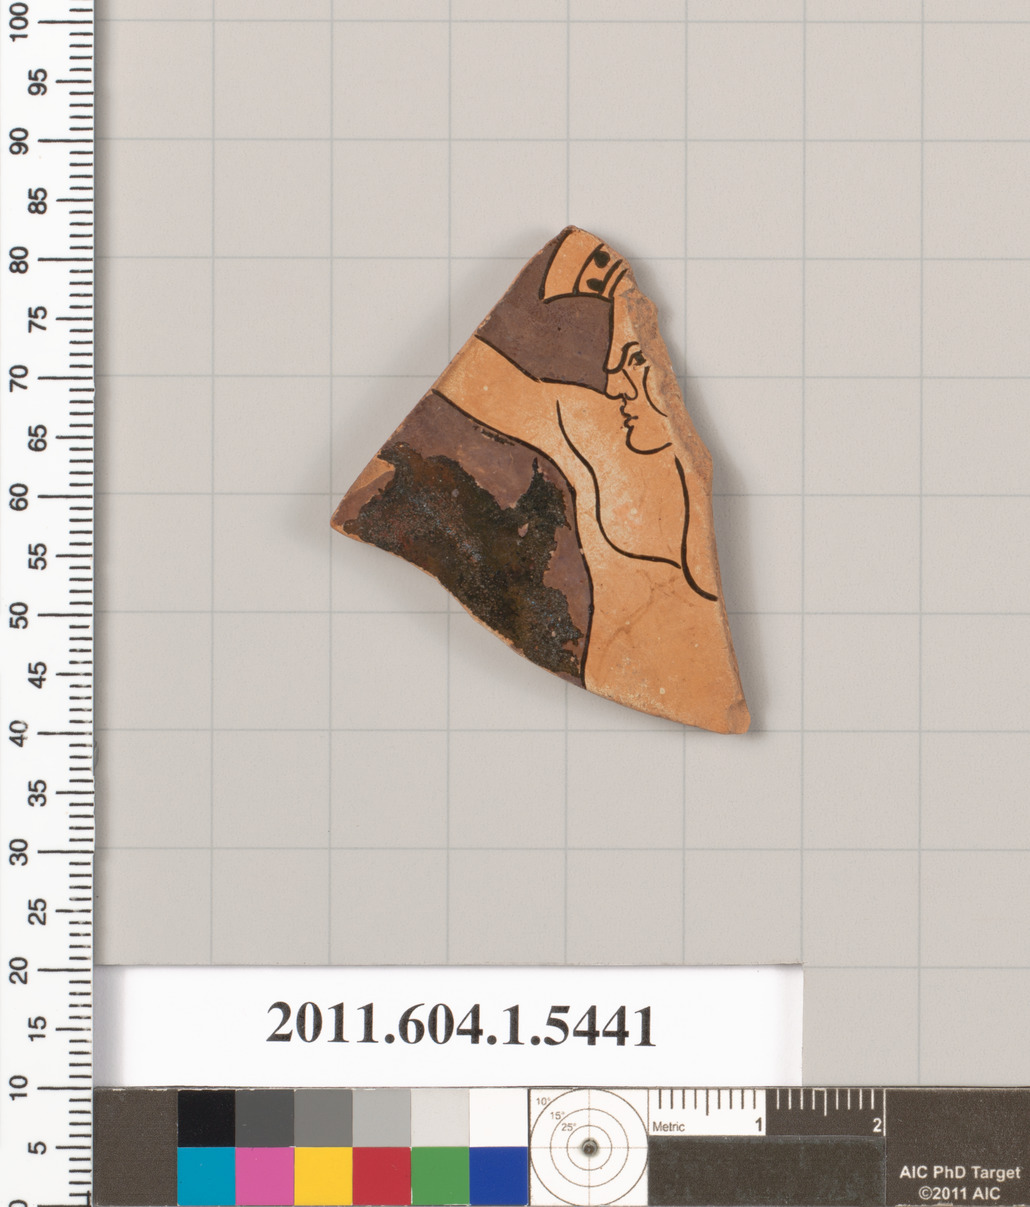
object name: kylix fragment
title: Terracotta fragment of a kylix (drinking cup)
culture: greek, attic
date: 520-510 BCE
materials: terracotta